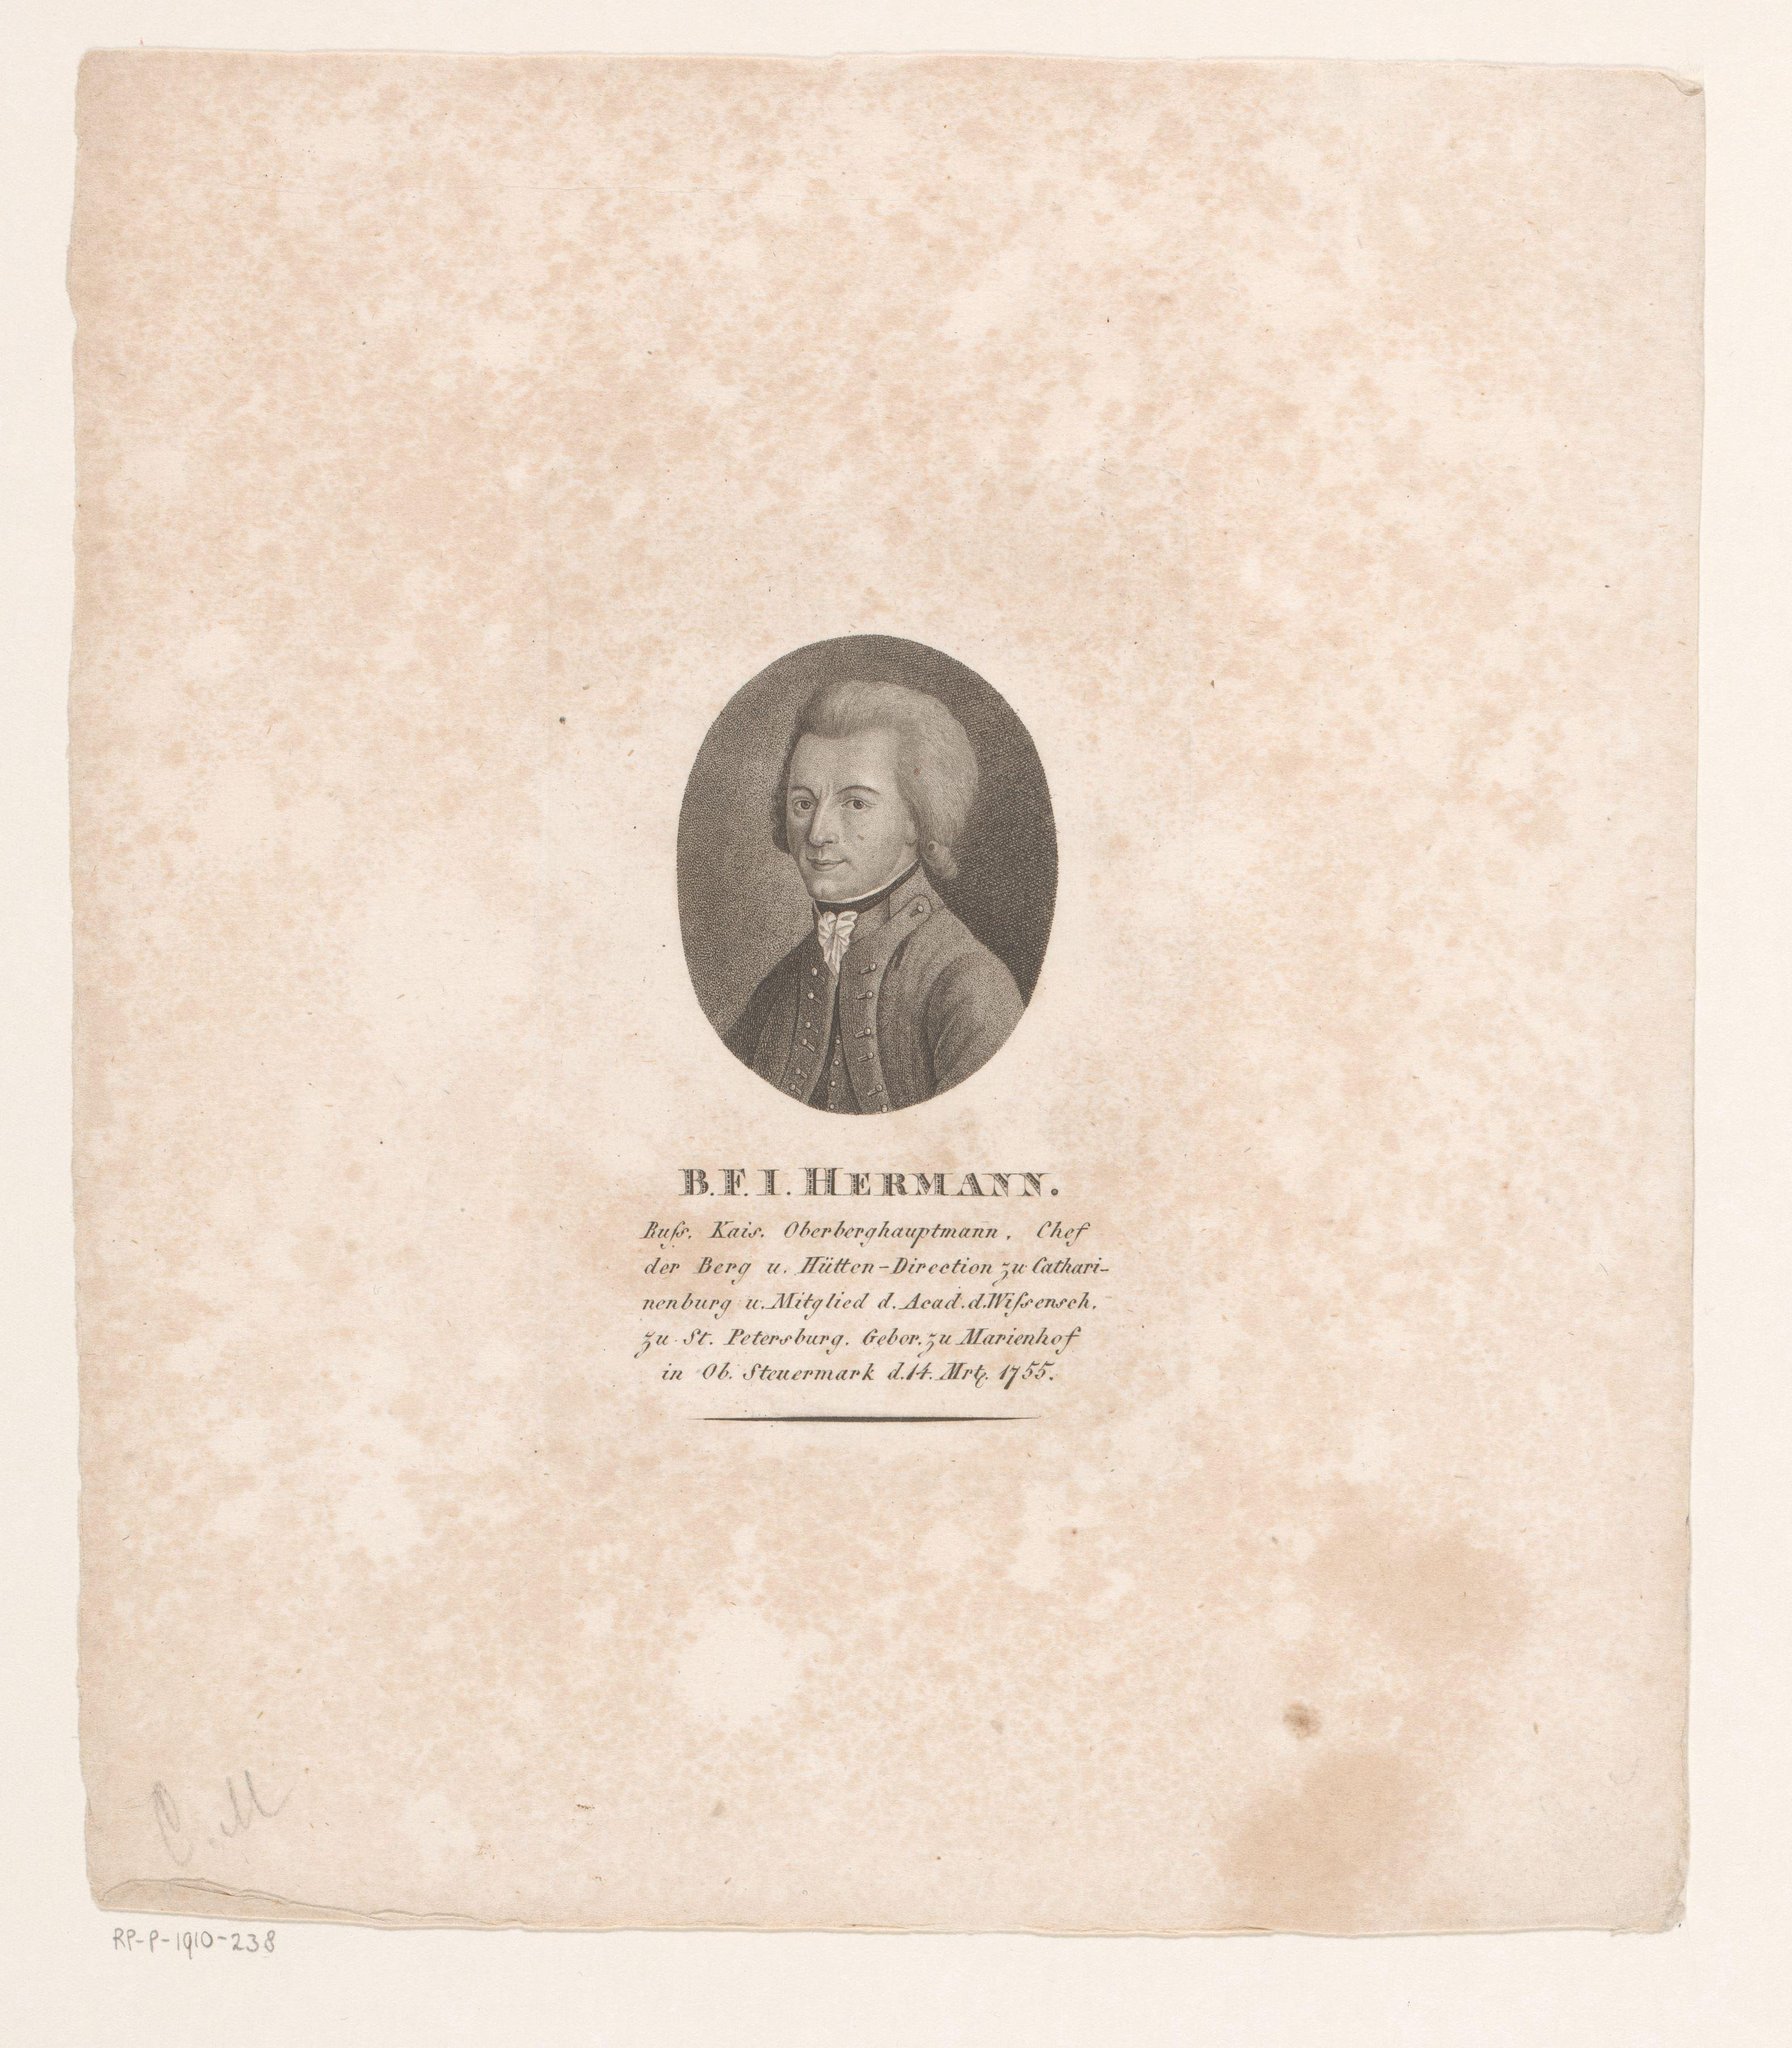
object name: print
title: Portret van Franz Benedikt Hermann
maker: konrad westermayr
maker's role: print maker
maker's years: 1765-1834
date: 1775-1834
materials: paper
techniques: engraving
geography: germany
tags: austria, historical persons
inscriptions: collector's mark: Lugt 2228